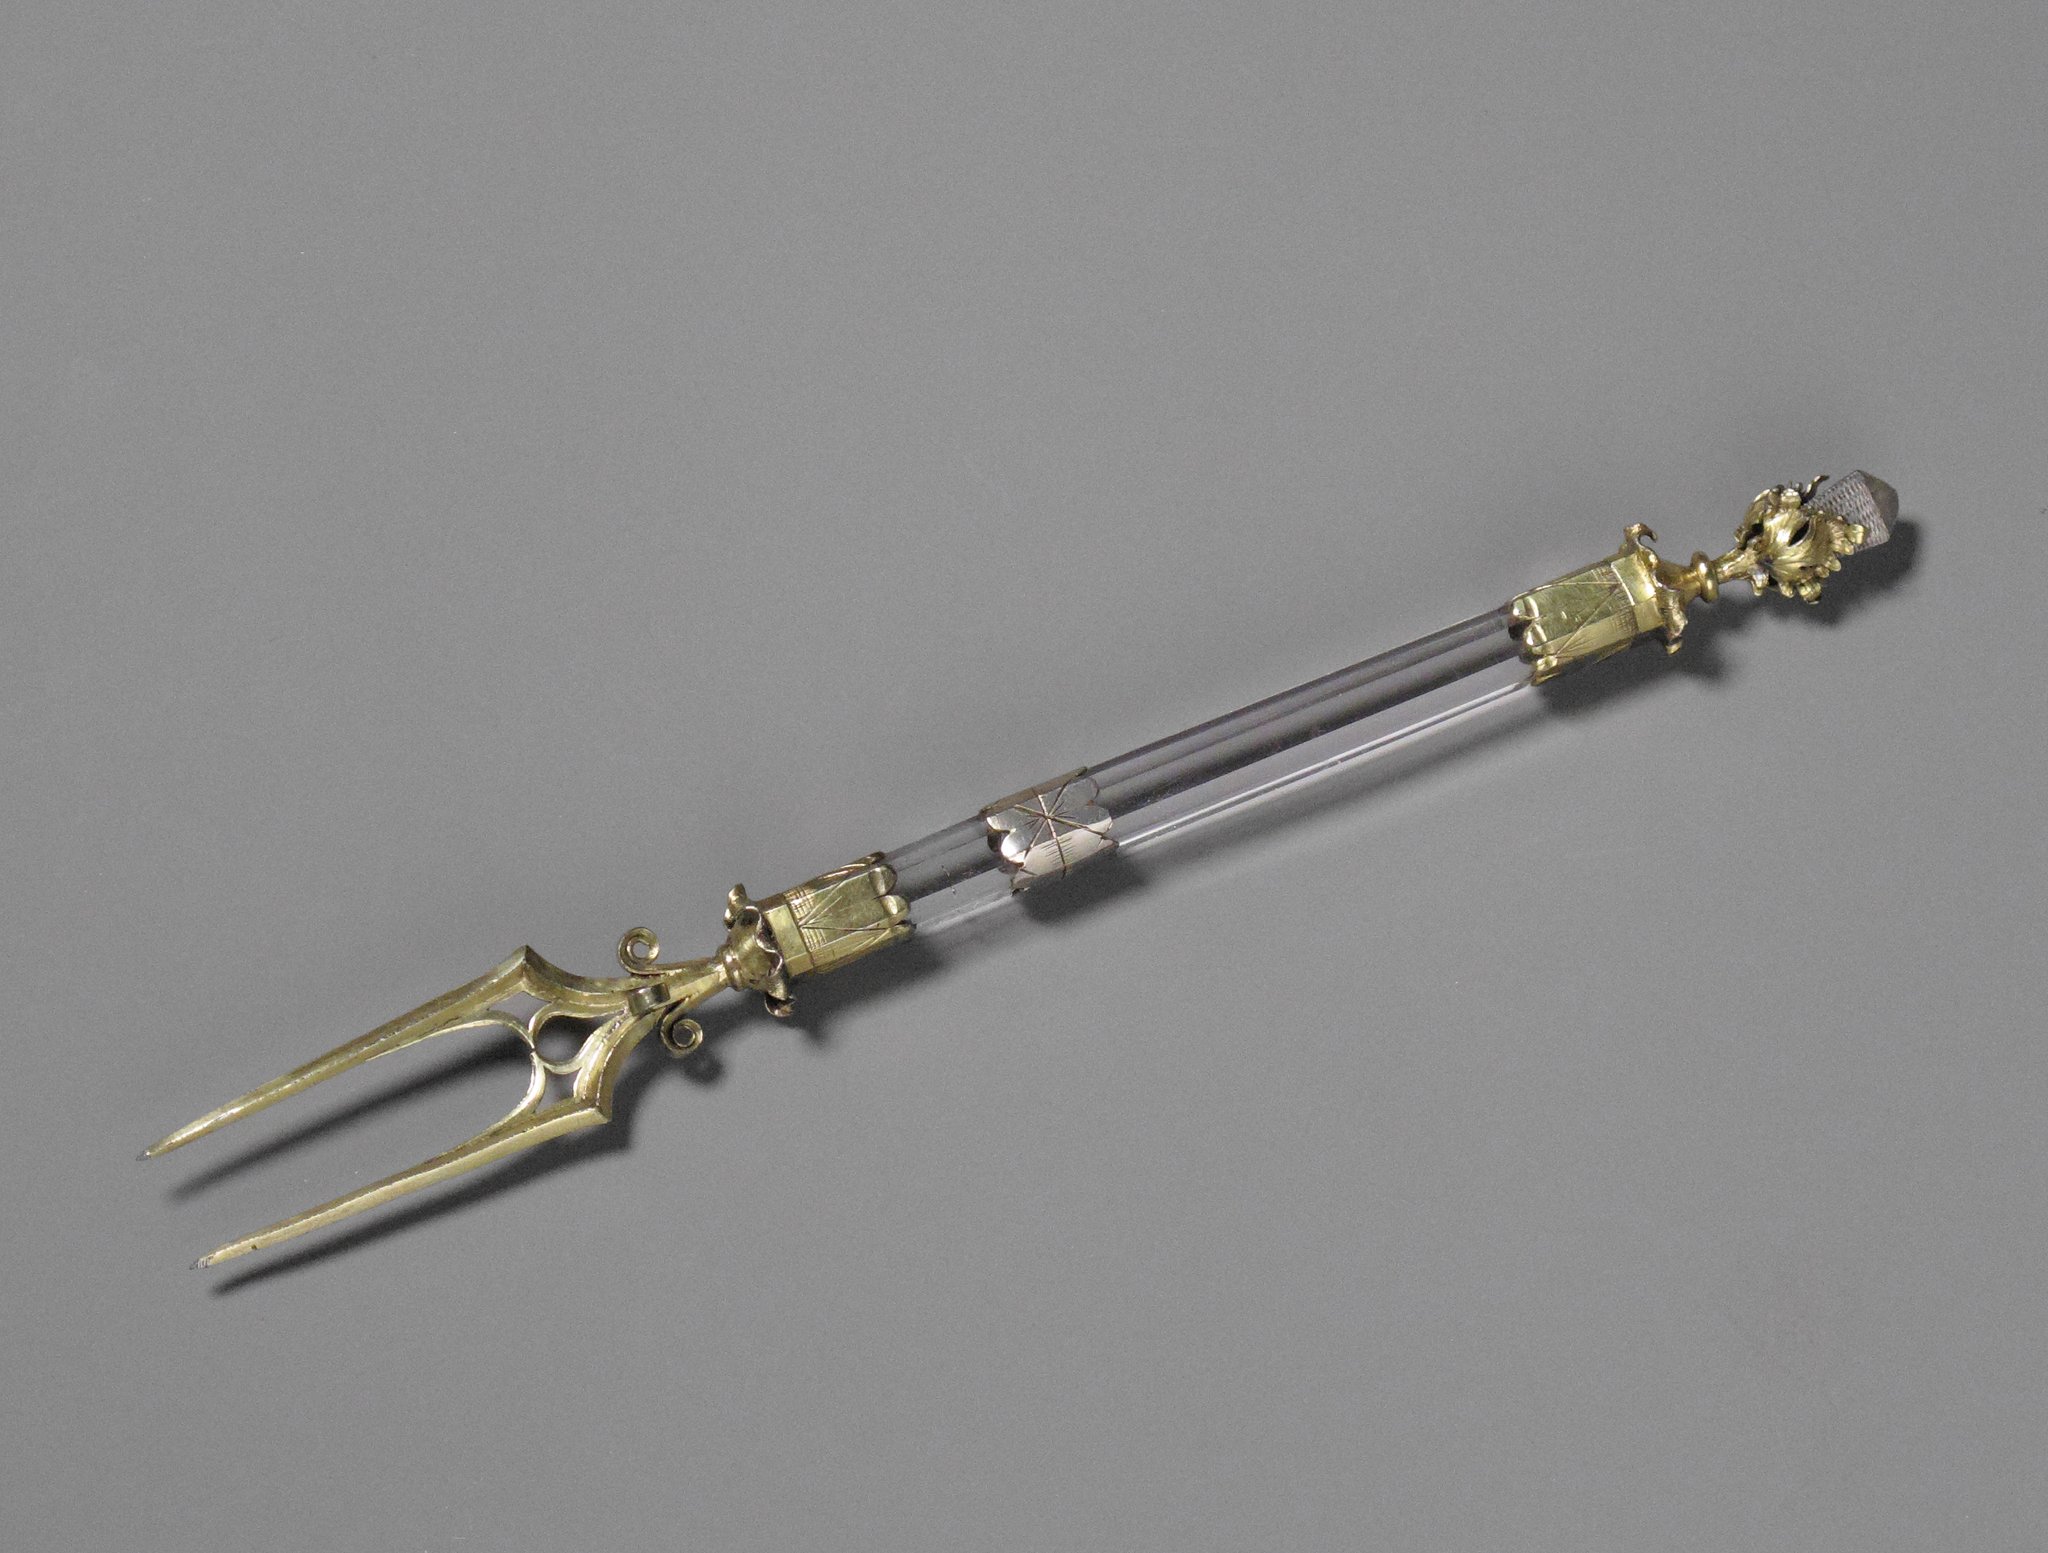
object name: fork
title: Sweetmeat Fork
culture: german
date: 1500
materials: quartz, silver, silver gilt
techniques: engraving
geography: germany